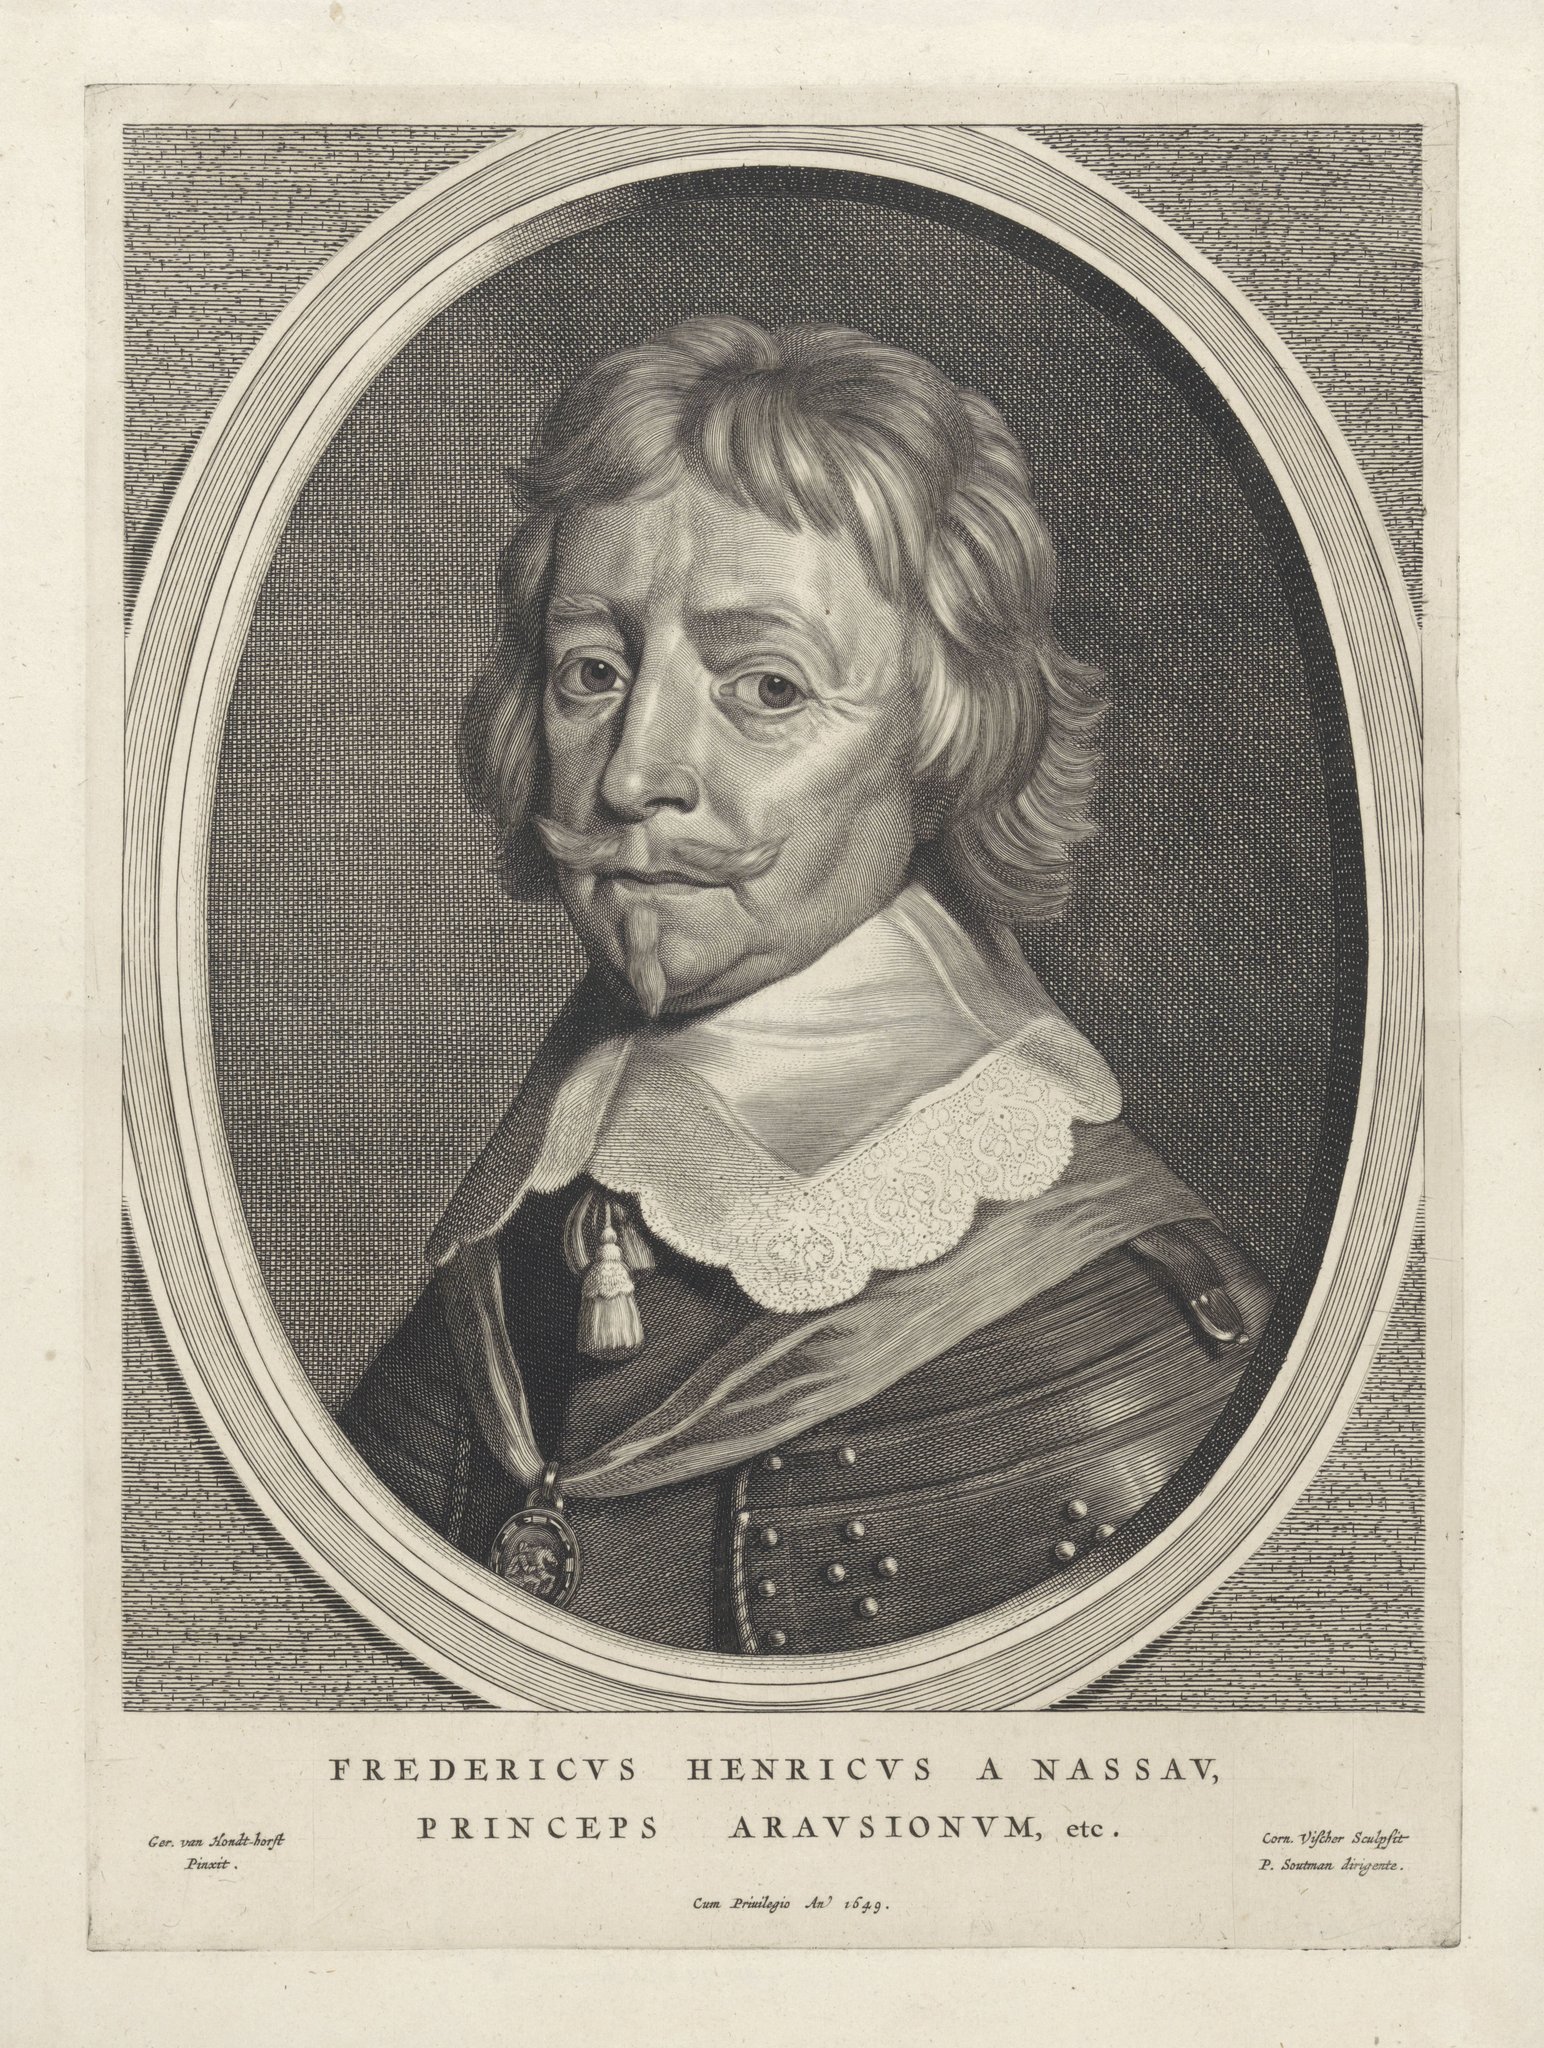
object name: print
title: Portret van Frederik Hendrik, prins van Oranje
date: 1649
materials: paper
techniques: engraving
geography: haarlem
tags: delft, the hague, frederick henry (prince of orange), knighthood order, armour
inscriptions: collector's mark: Lugt 240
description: Frederik Hendrik, prins van Oranje-Nassau in een harnas. Om zijn hals het ordeteken van de orde van de Kousenband. Prent uit een serie van 9 prenten met Oranjeportretten.